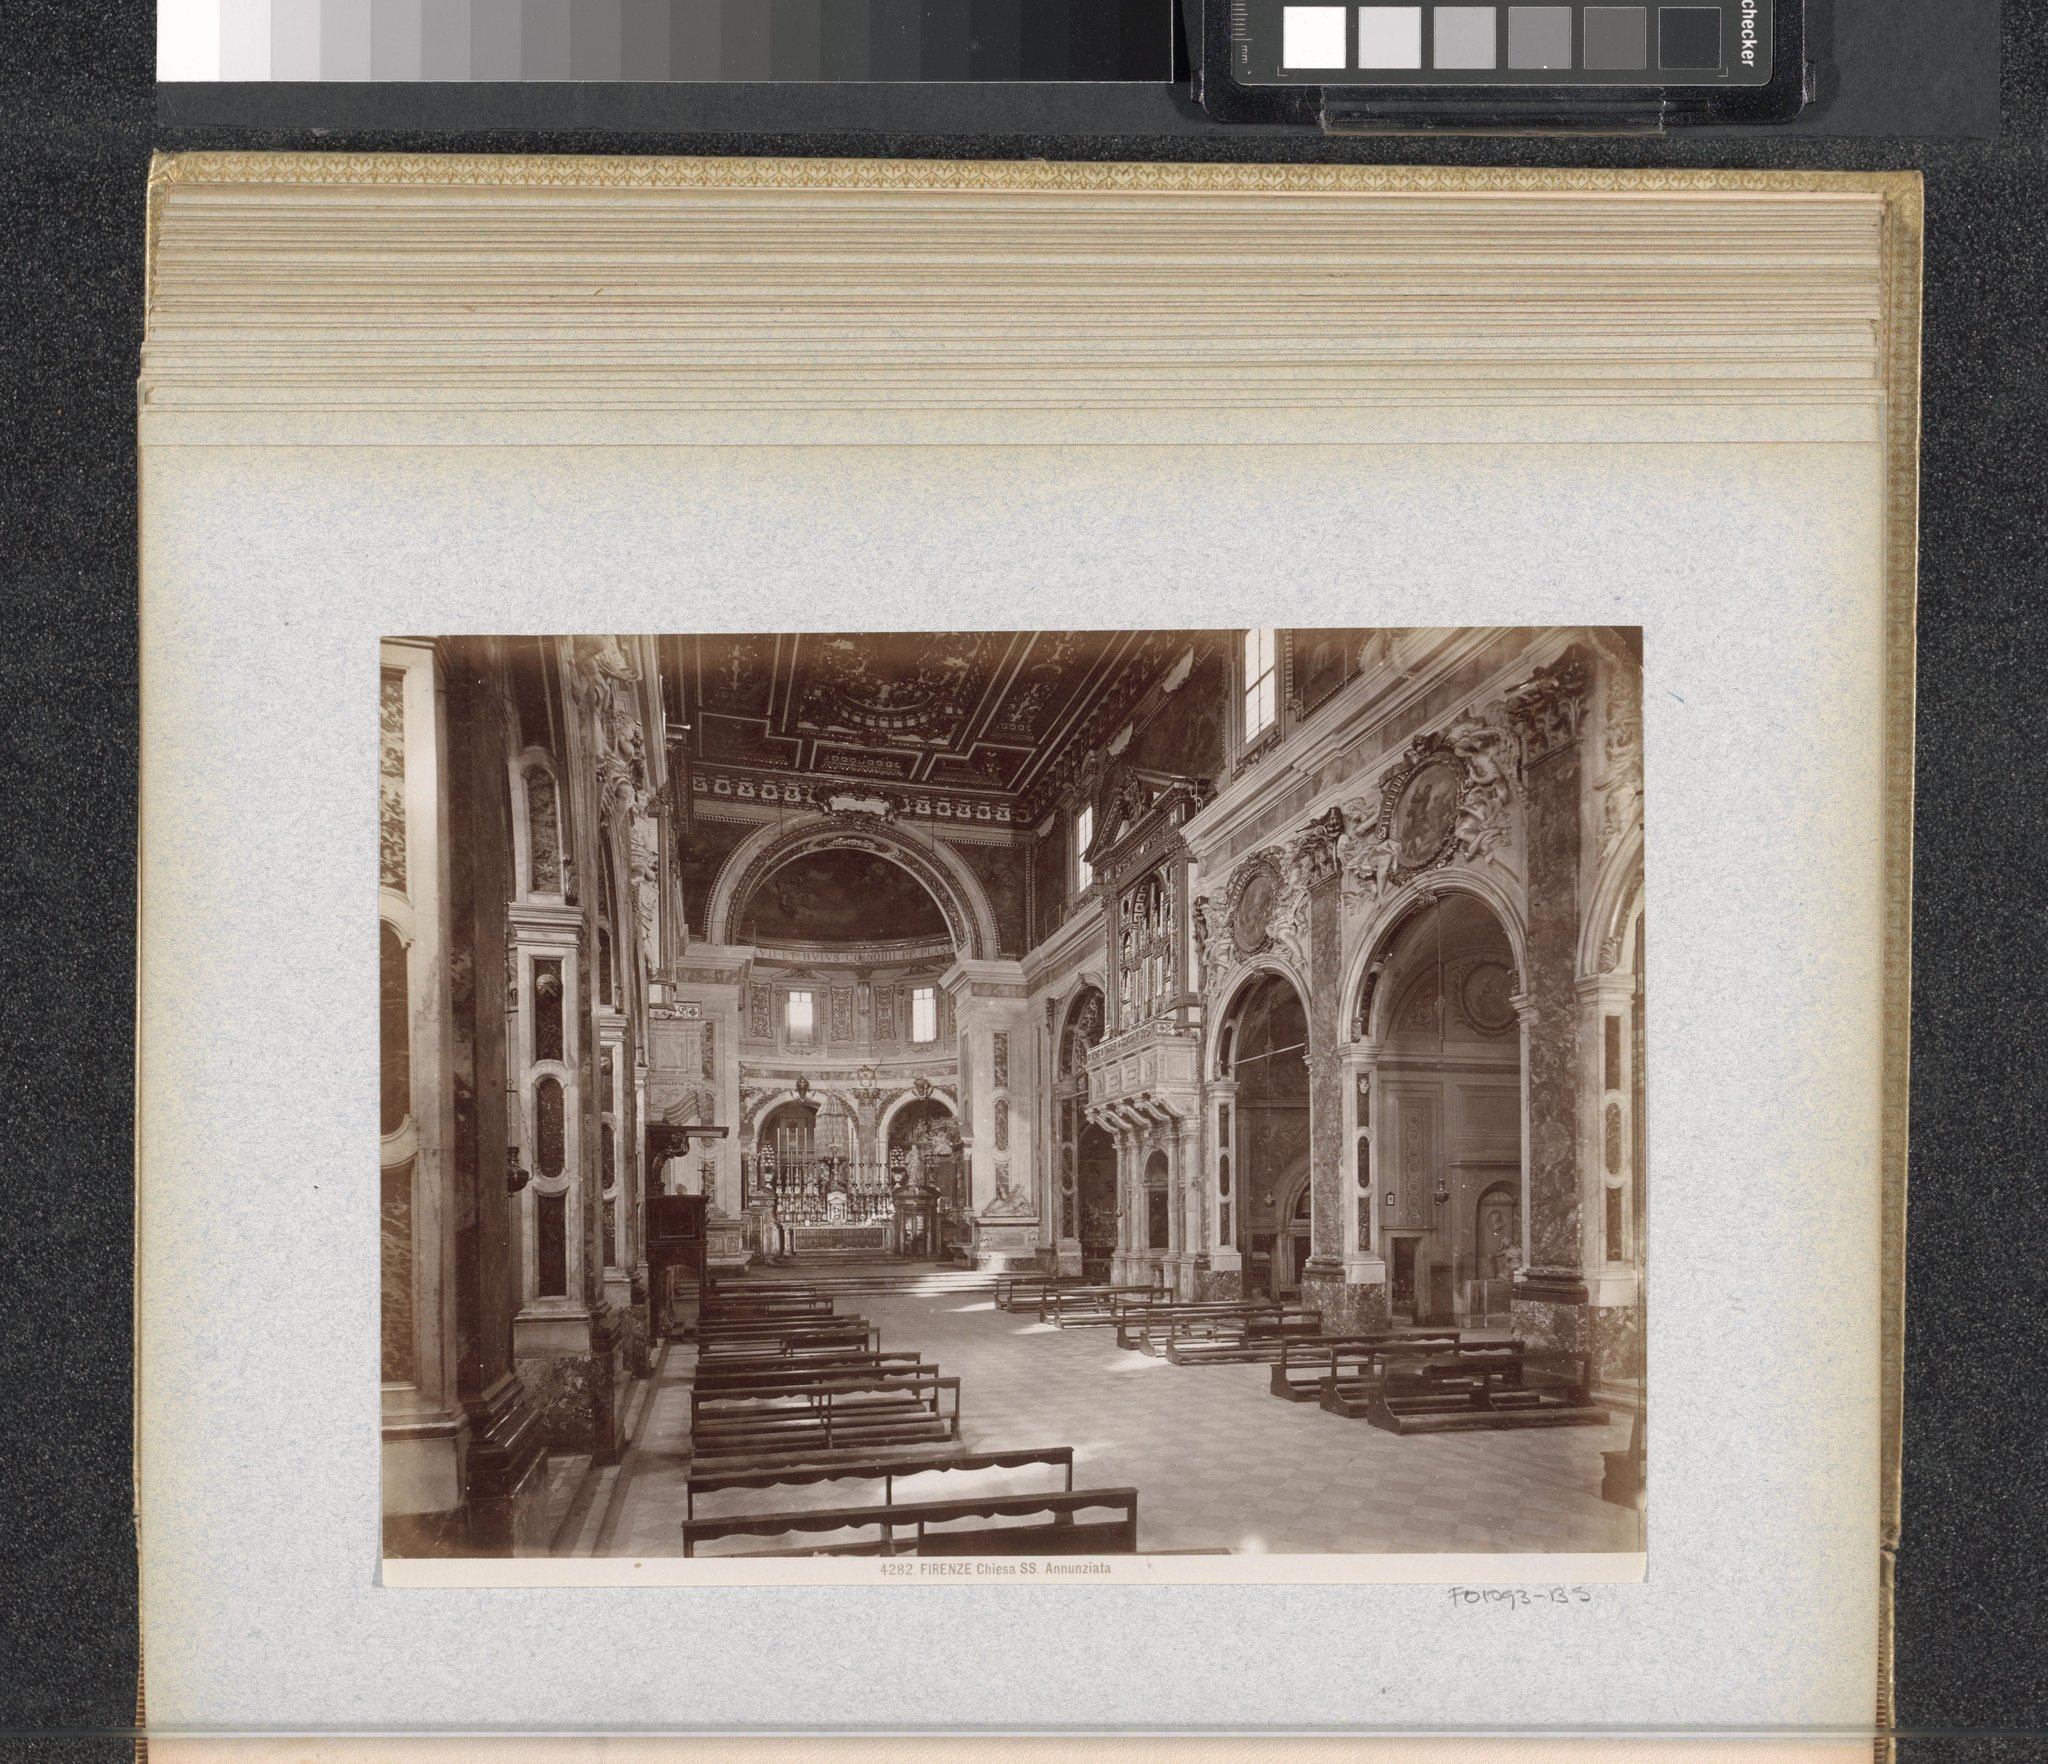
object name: photograph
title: FIRENZE Chiesa SS. Annunziata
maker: Anonymous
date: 1870-1890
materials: paper, photographic support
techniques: albumen print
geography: florence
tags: parts of church interior: nave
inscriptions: negative number: ‘4282’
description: Onderdeel van Reisalbum met foto's van bezienswaardigheden in Genua, Florence en Venetië.